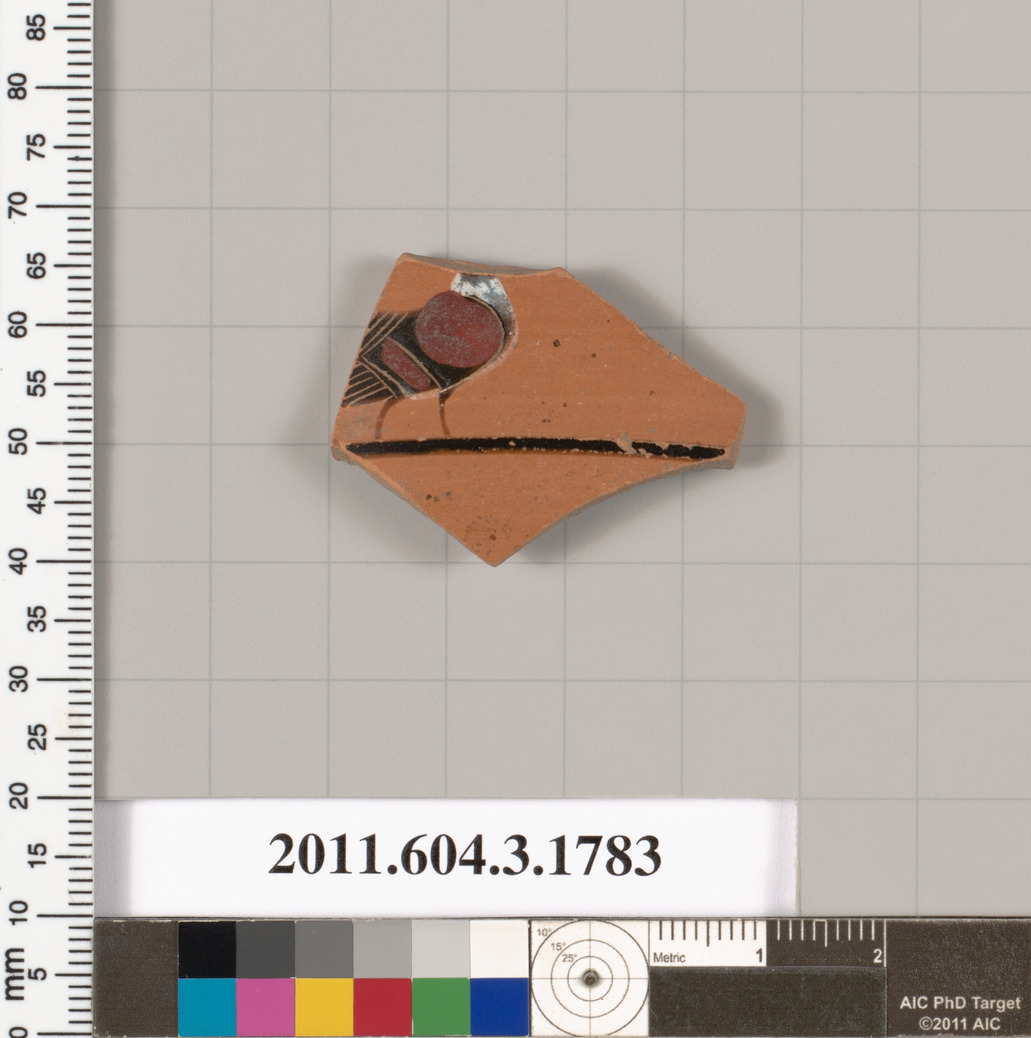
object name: kylix fragment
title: Terracotta rim fragment of a kylix: Lip cup (drinking cup)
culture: greek, attic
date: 560-550 BCE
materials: terracotta